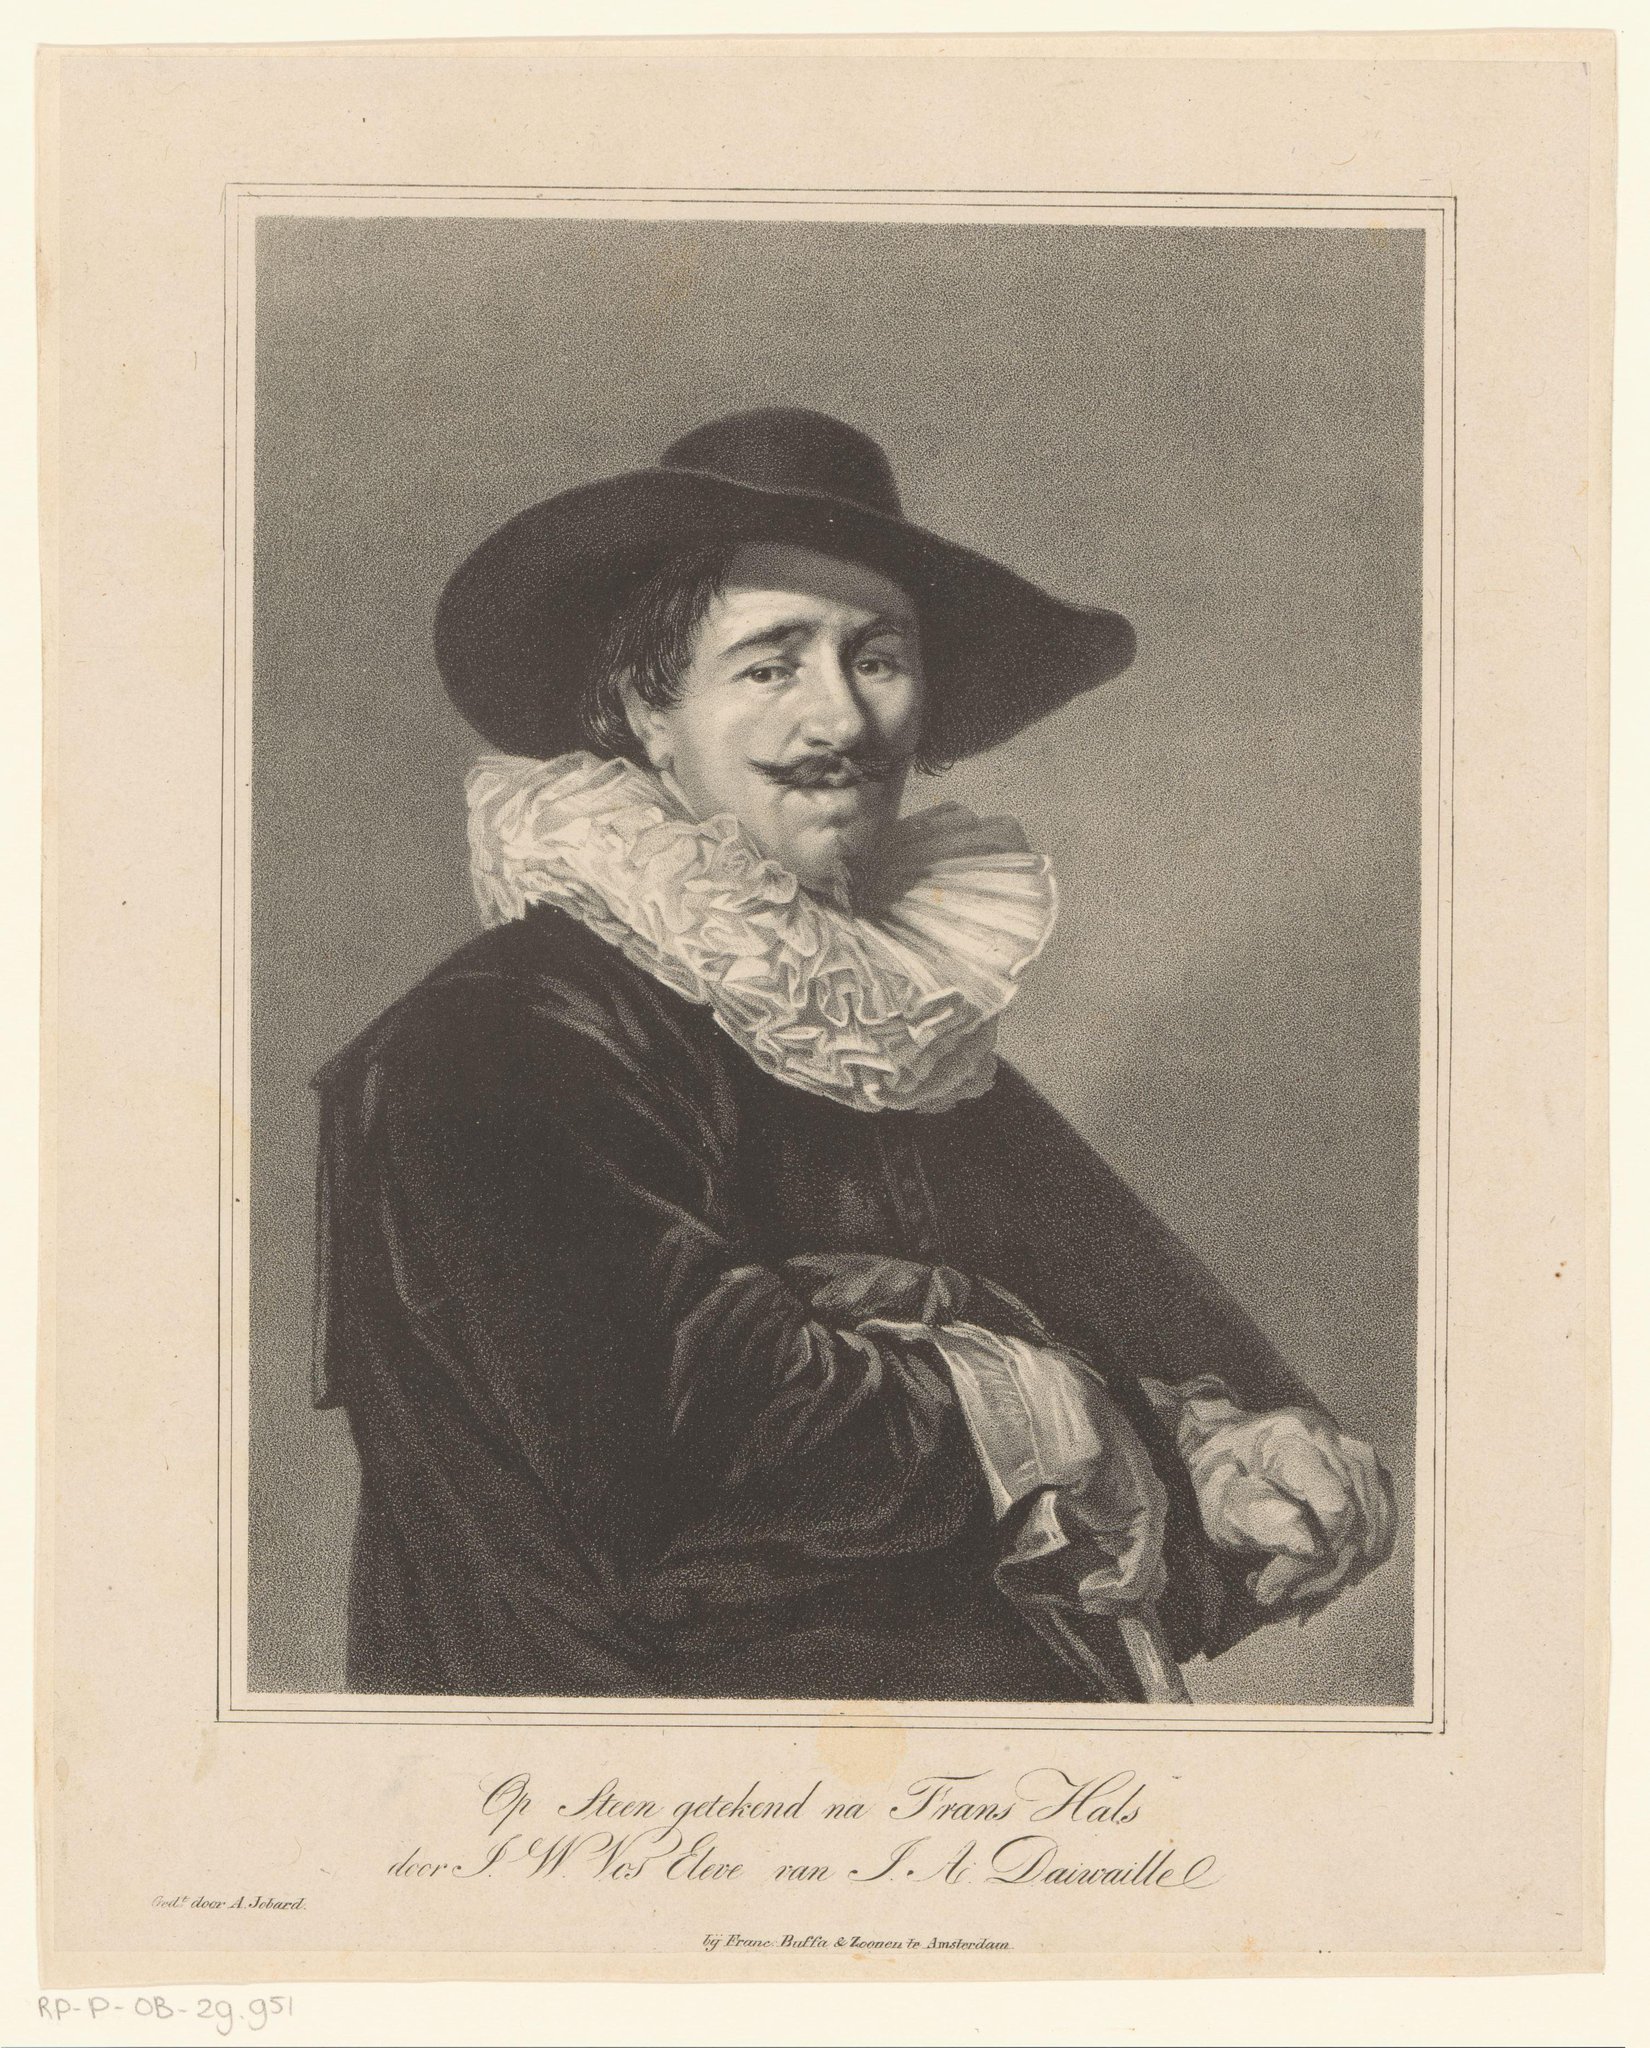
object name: print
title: Zelfportret van Frans Hals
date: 1827-1828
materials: paper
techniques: lithograph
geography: amsterdam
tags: antwerp, haarlem, draughtsman, frans hals, historical persons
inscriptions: collector's mark: Lugt 2228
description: Het schilderij van Frans Hals uit 1638 bevindt zich in het Museu de Arte de São Paulo.